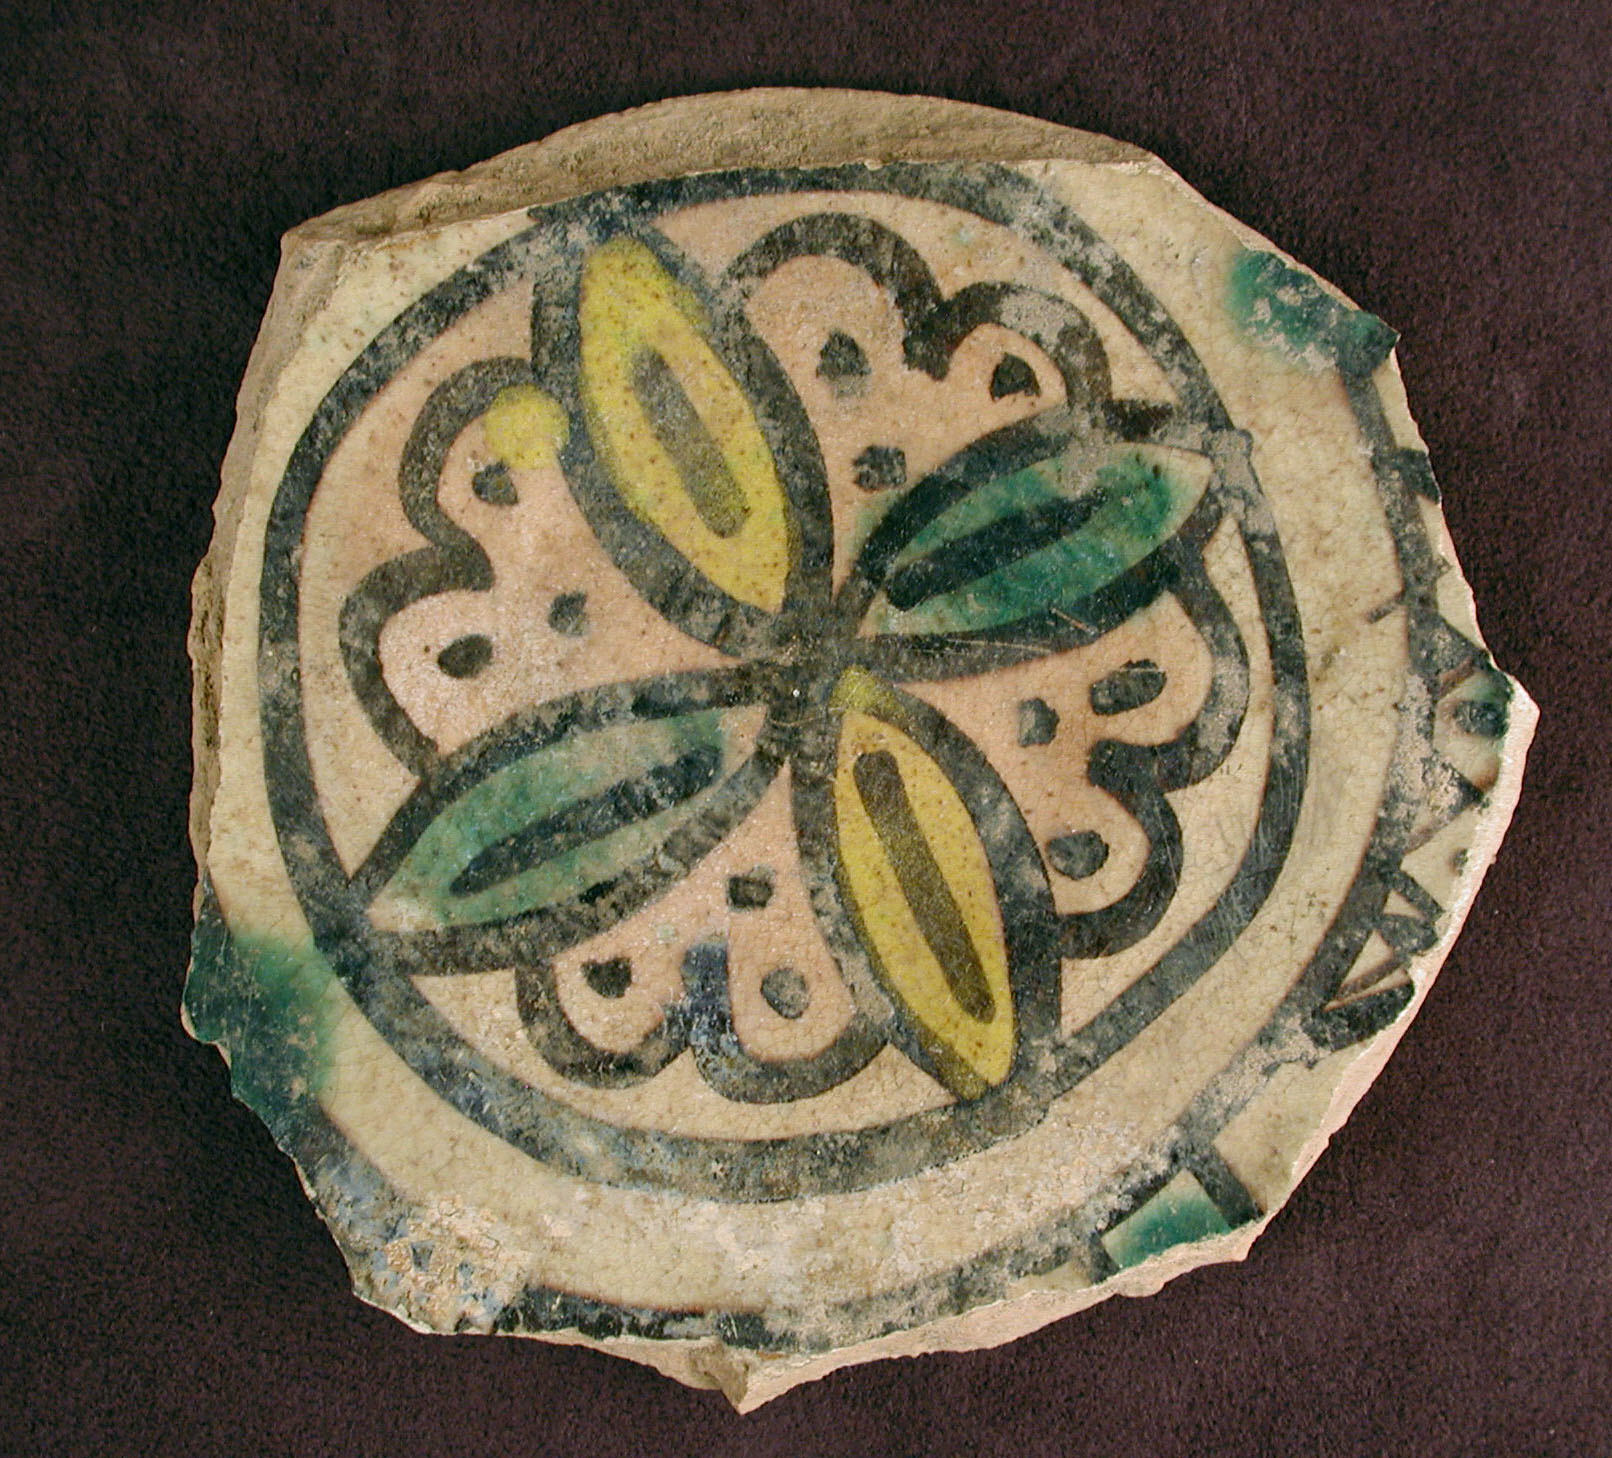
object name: fragment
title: Base of a Buff Ware Vessel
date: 801-1000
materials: earthenware, glaze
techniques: polychrome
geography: iran